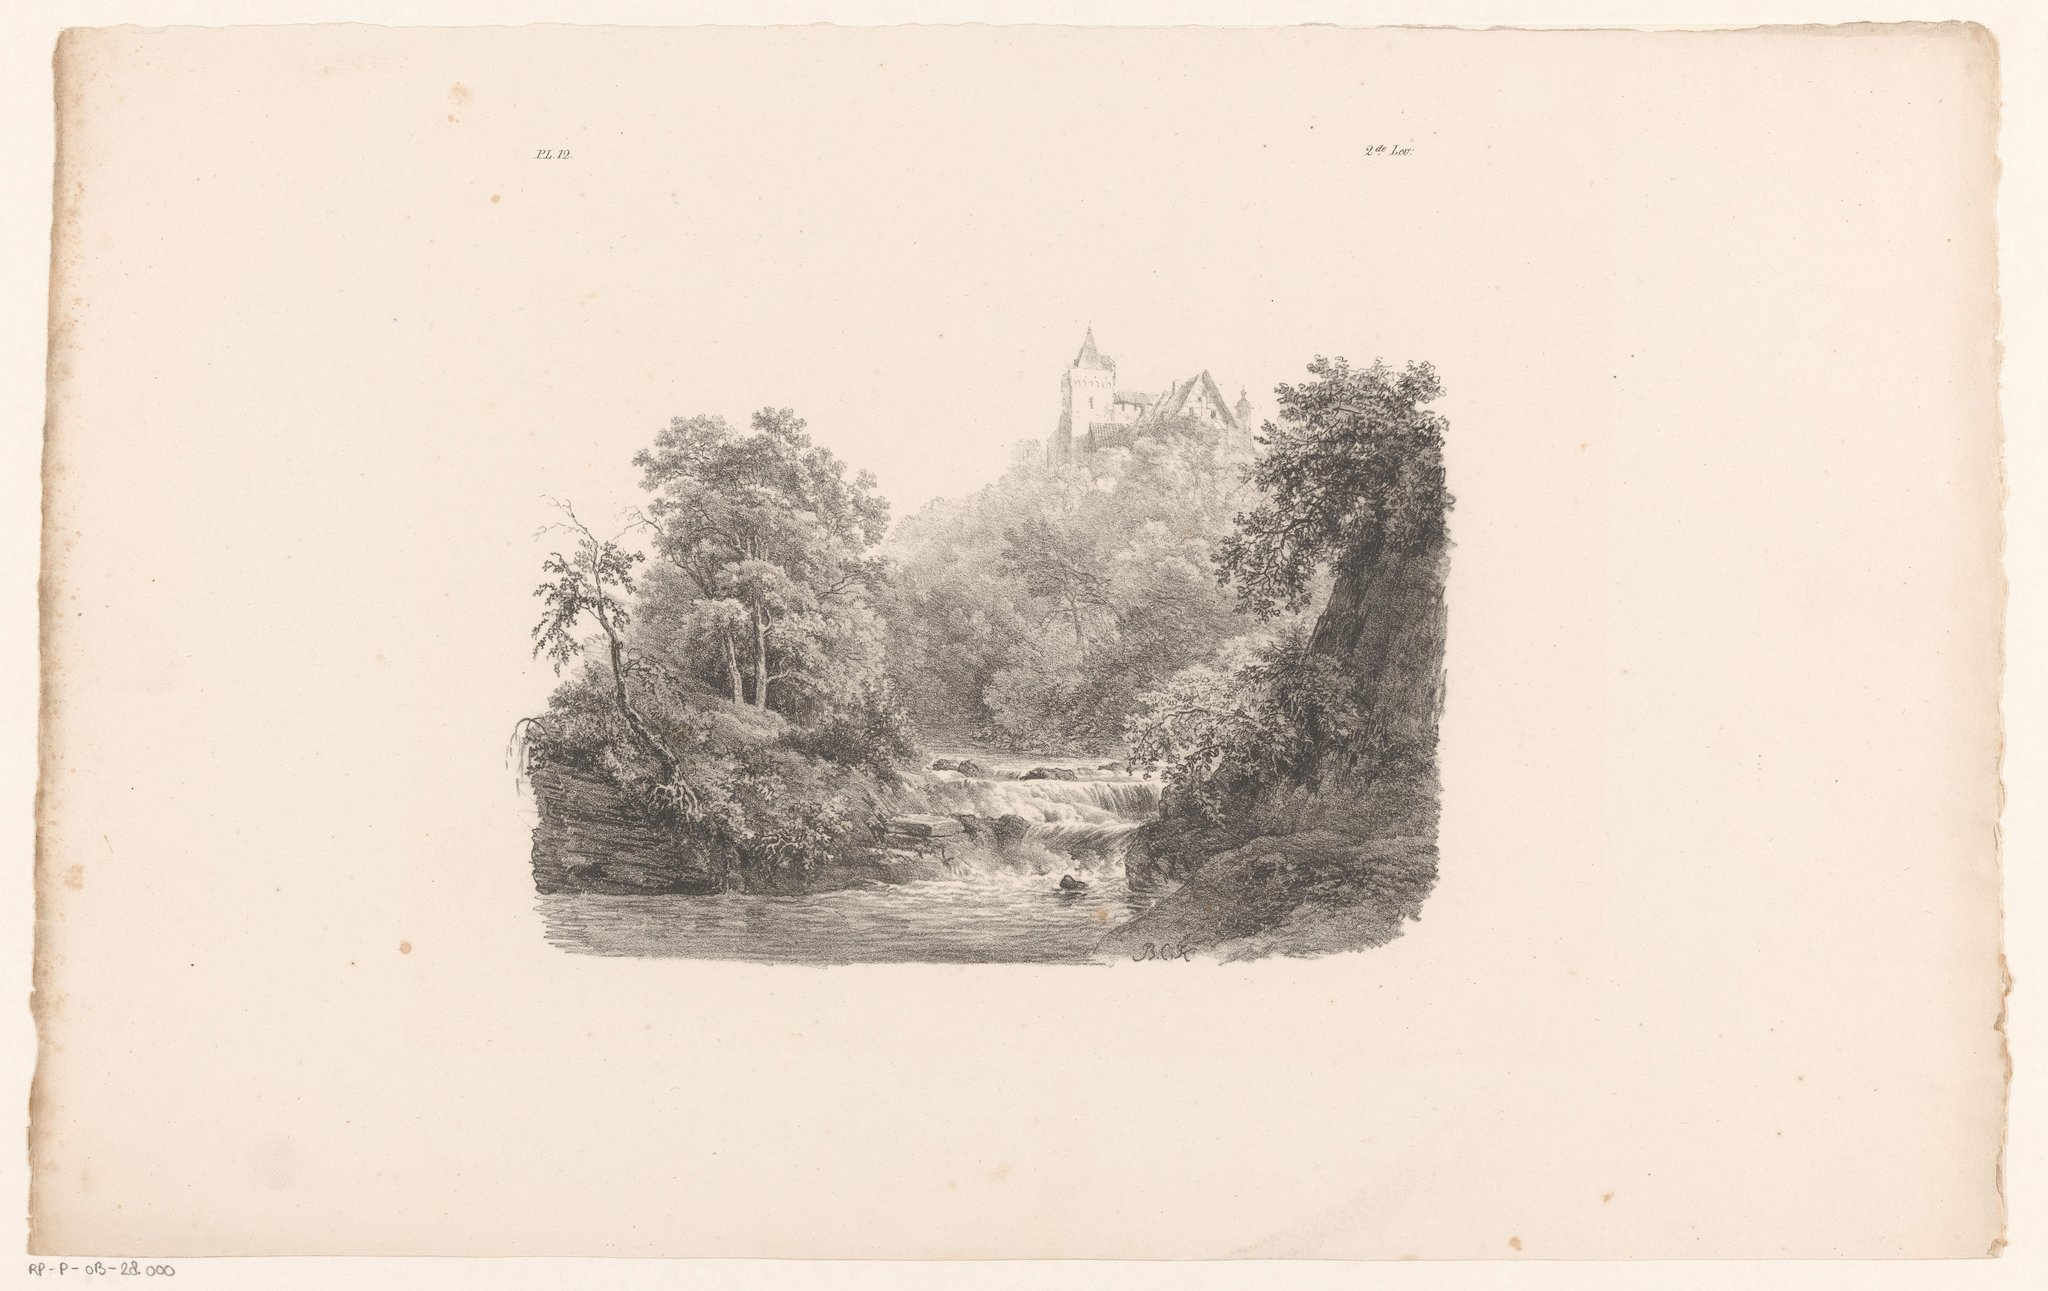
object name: print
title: Landschap met kasteel Landsberg bij Kettwig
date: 1813-1862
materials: paper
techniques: lithograph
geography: amsterdam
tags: rapids, landscape with tower or castle - ii - ideal landscapes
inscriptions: collector's mark: Lugt 2228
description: Zie 'De Hollandse jaren van Barend Cornelis Koekkoek' door C. J. de Bruyn Kops in Bulletin van het Rijksmuseum.